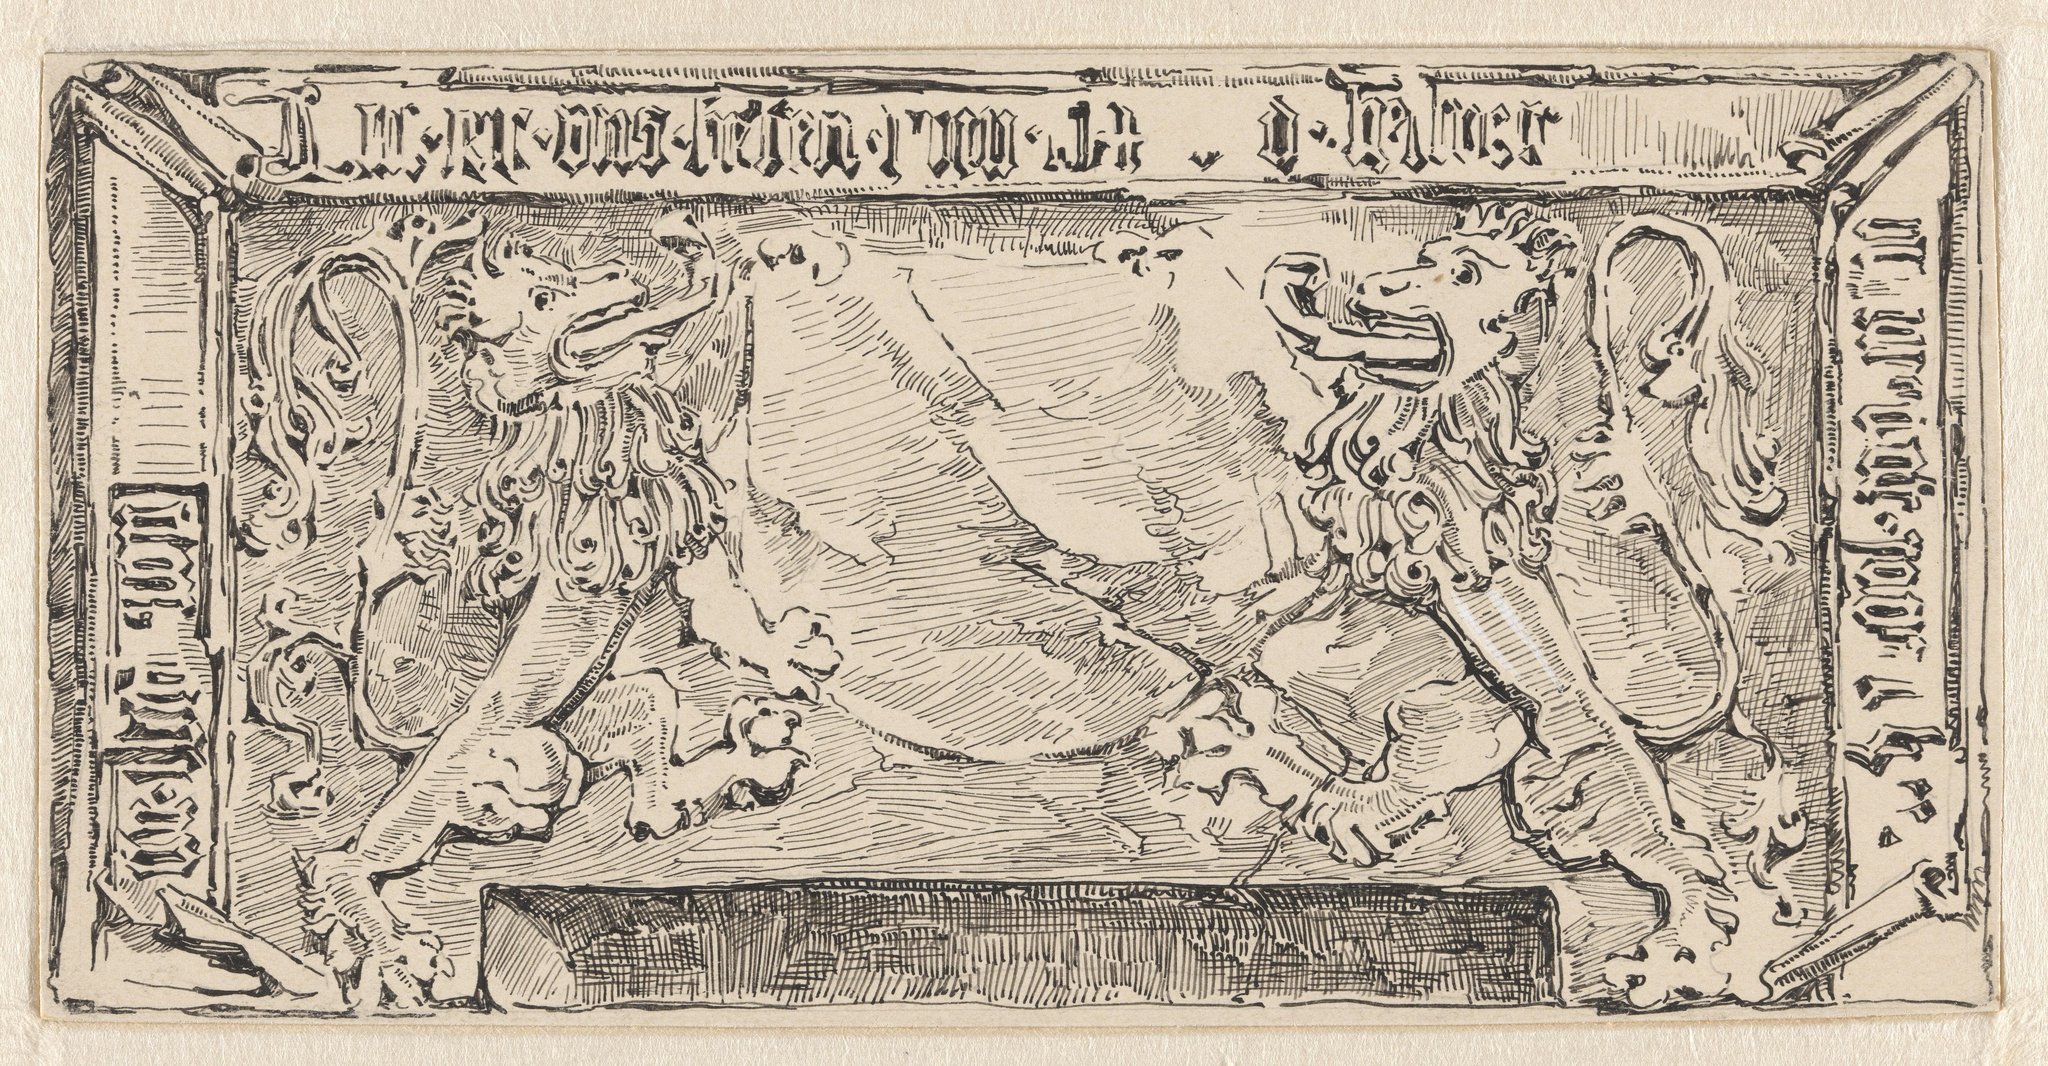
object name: drawing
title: Steen in de westgevel van de Nederlands Hervormde kerk te Egmond aan den Hoef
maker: jacobus gerardus veldheer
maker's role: draughtsman, print maker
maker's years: 1866-1954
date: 1876-1903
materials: cardboard, paint, ink, pencil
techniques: brush, pen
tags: piece of sculpture, reproduction of a piece of sculpture, egmond aan den hoef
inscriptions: collector's mark: Lugt 2228, annotation: ‘Gothische steen in den Westgevel/ der N. H. Kerk te Egmond aan den hoef’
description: Gevelsteen met twee leeuwen die een wapenschild tonen en tekst aan de boven- en zijkant.